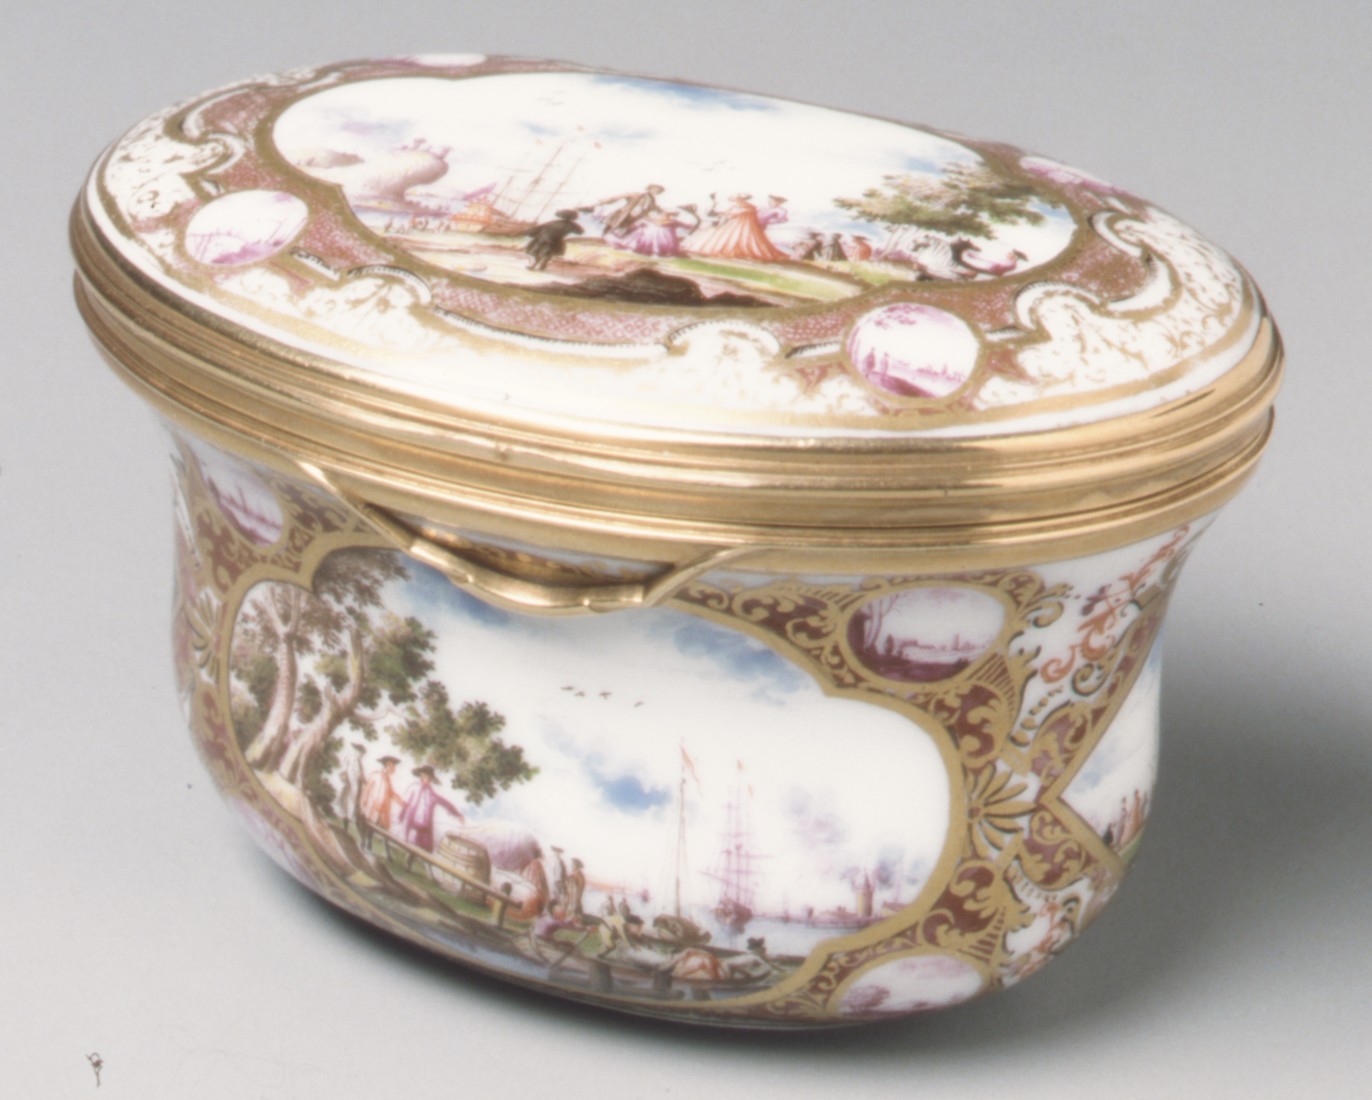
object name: snuffbox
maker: meissen manufactory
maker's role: manufactory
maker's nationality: german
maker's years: 1710-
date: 1730-1735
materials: gold, hard paste porcelain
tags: infants,men,women